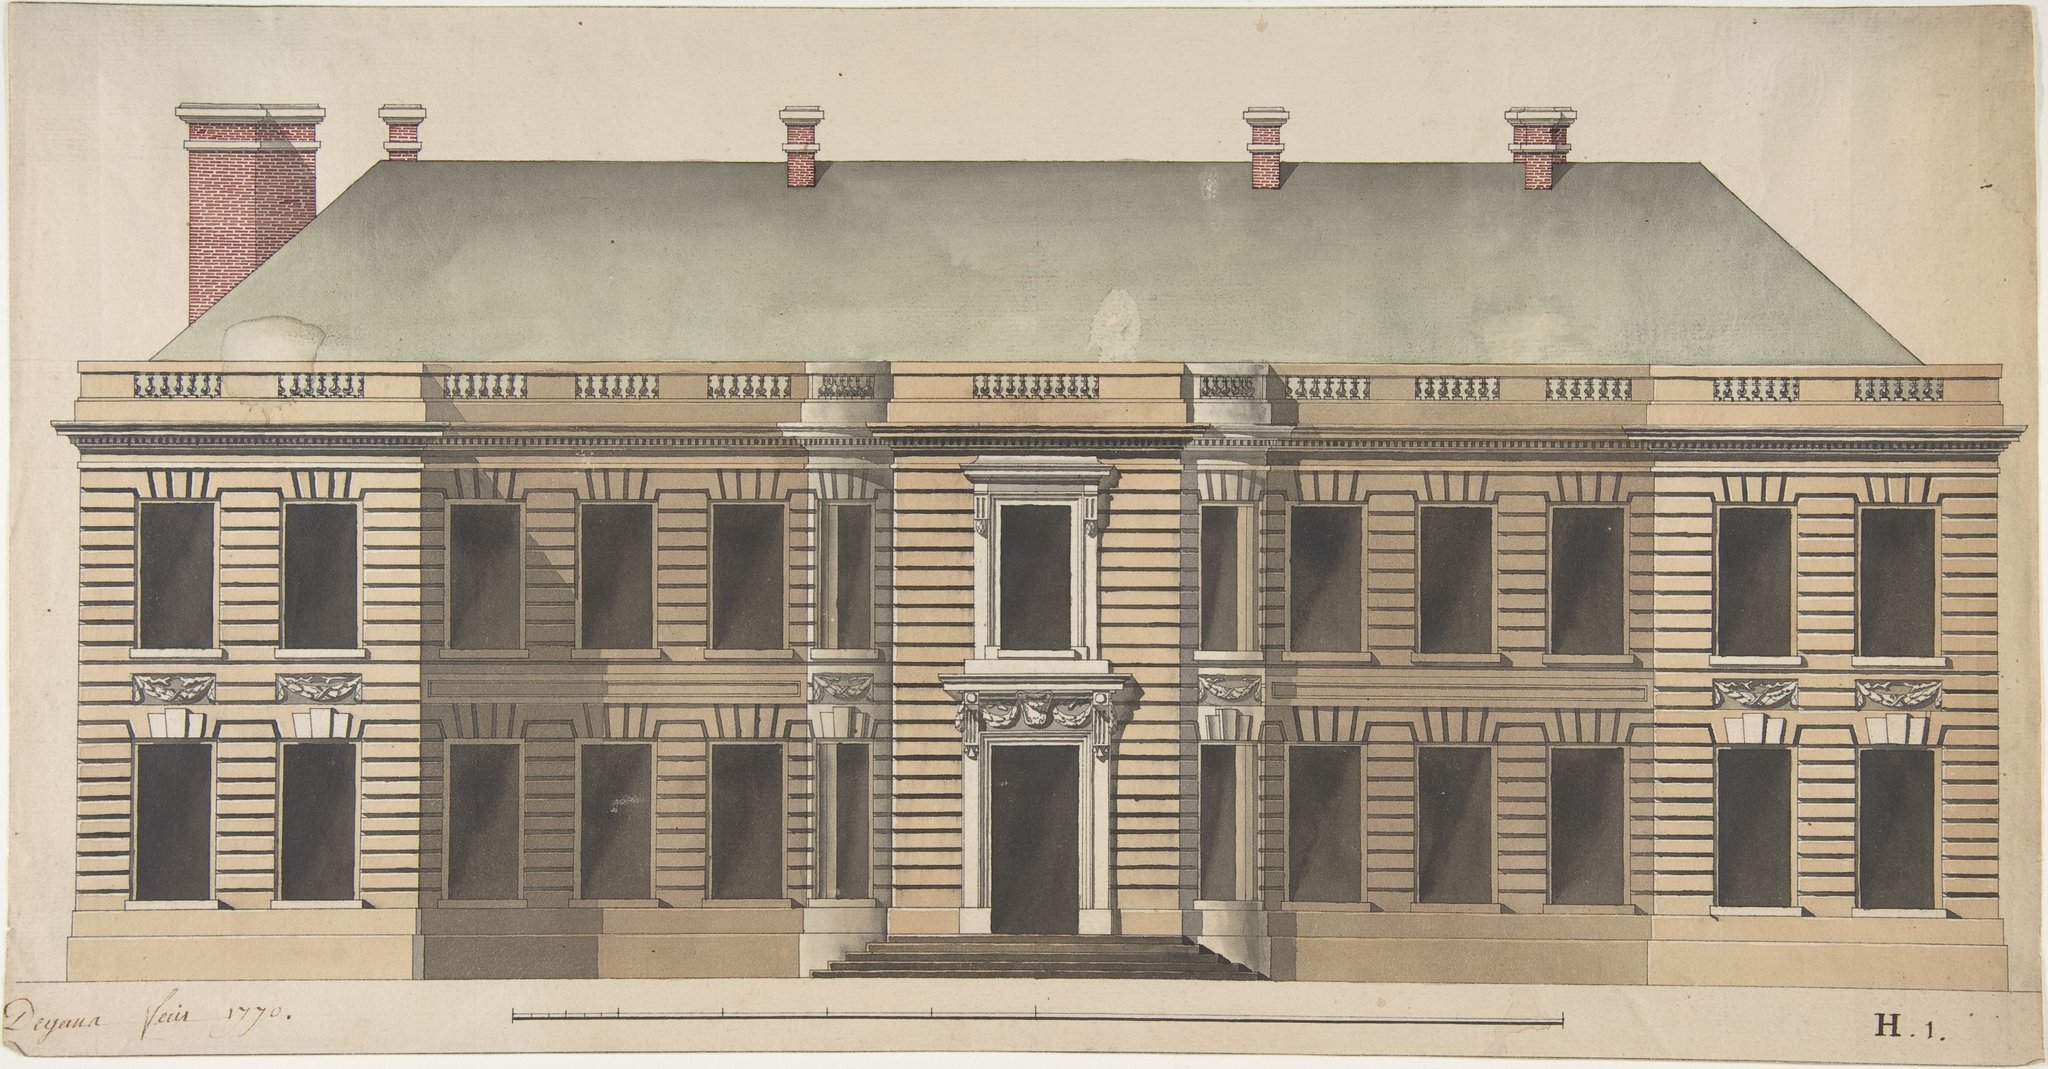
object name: drawing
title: Elevation for a Palace Façade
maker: degana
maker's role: artist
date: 1770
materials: graphite, ink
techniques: brush, pen, wash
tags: architecture,palaces